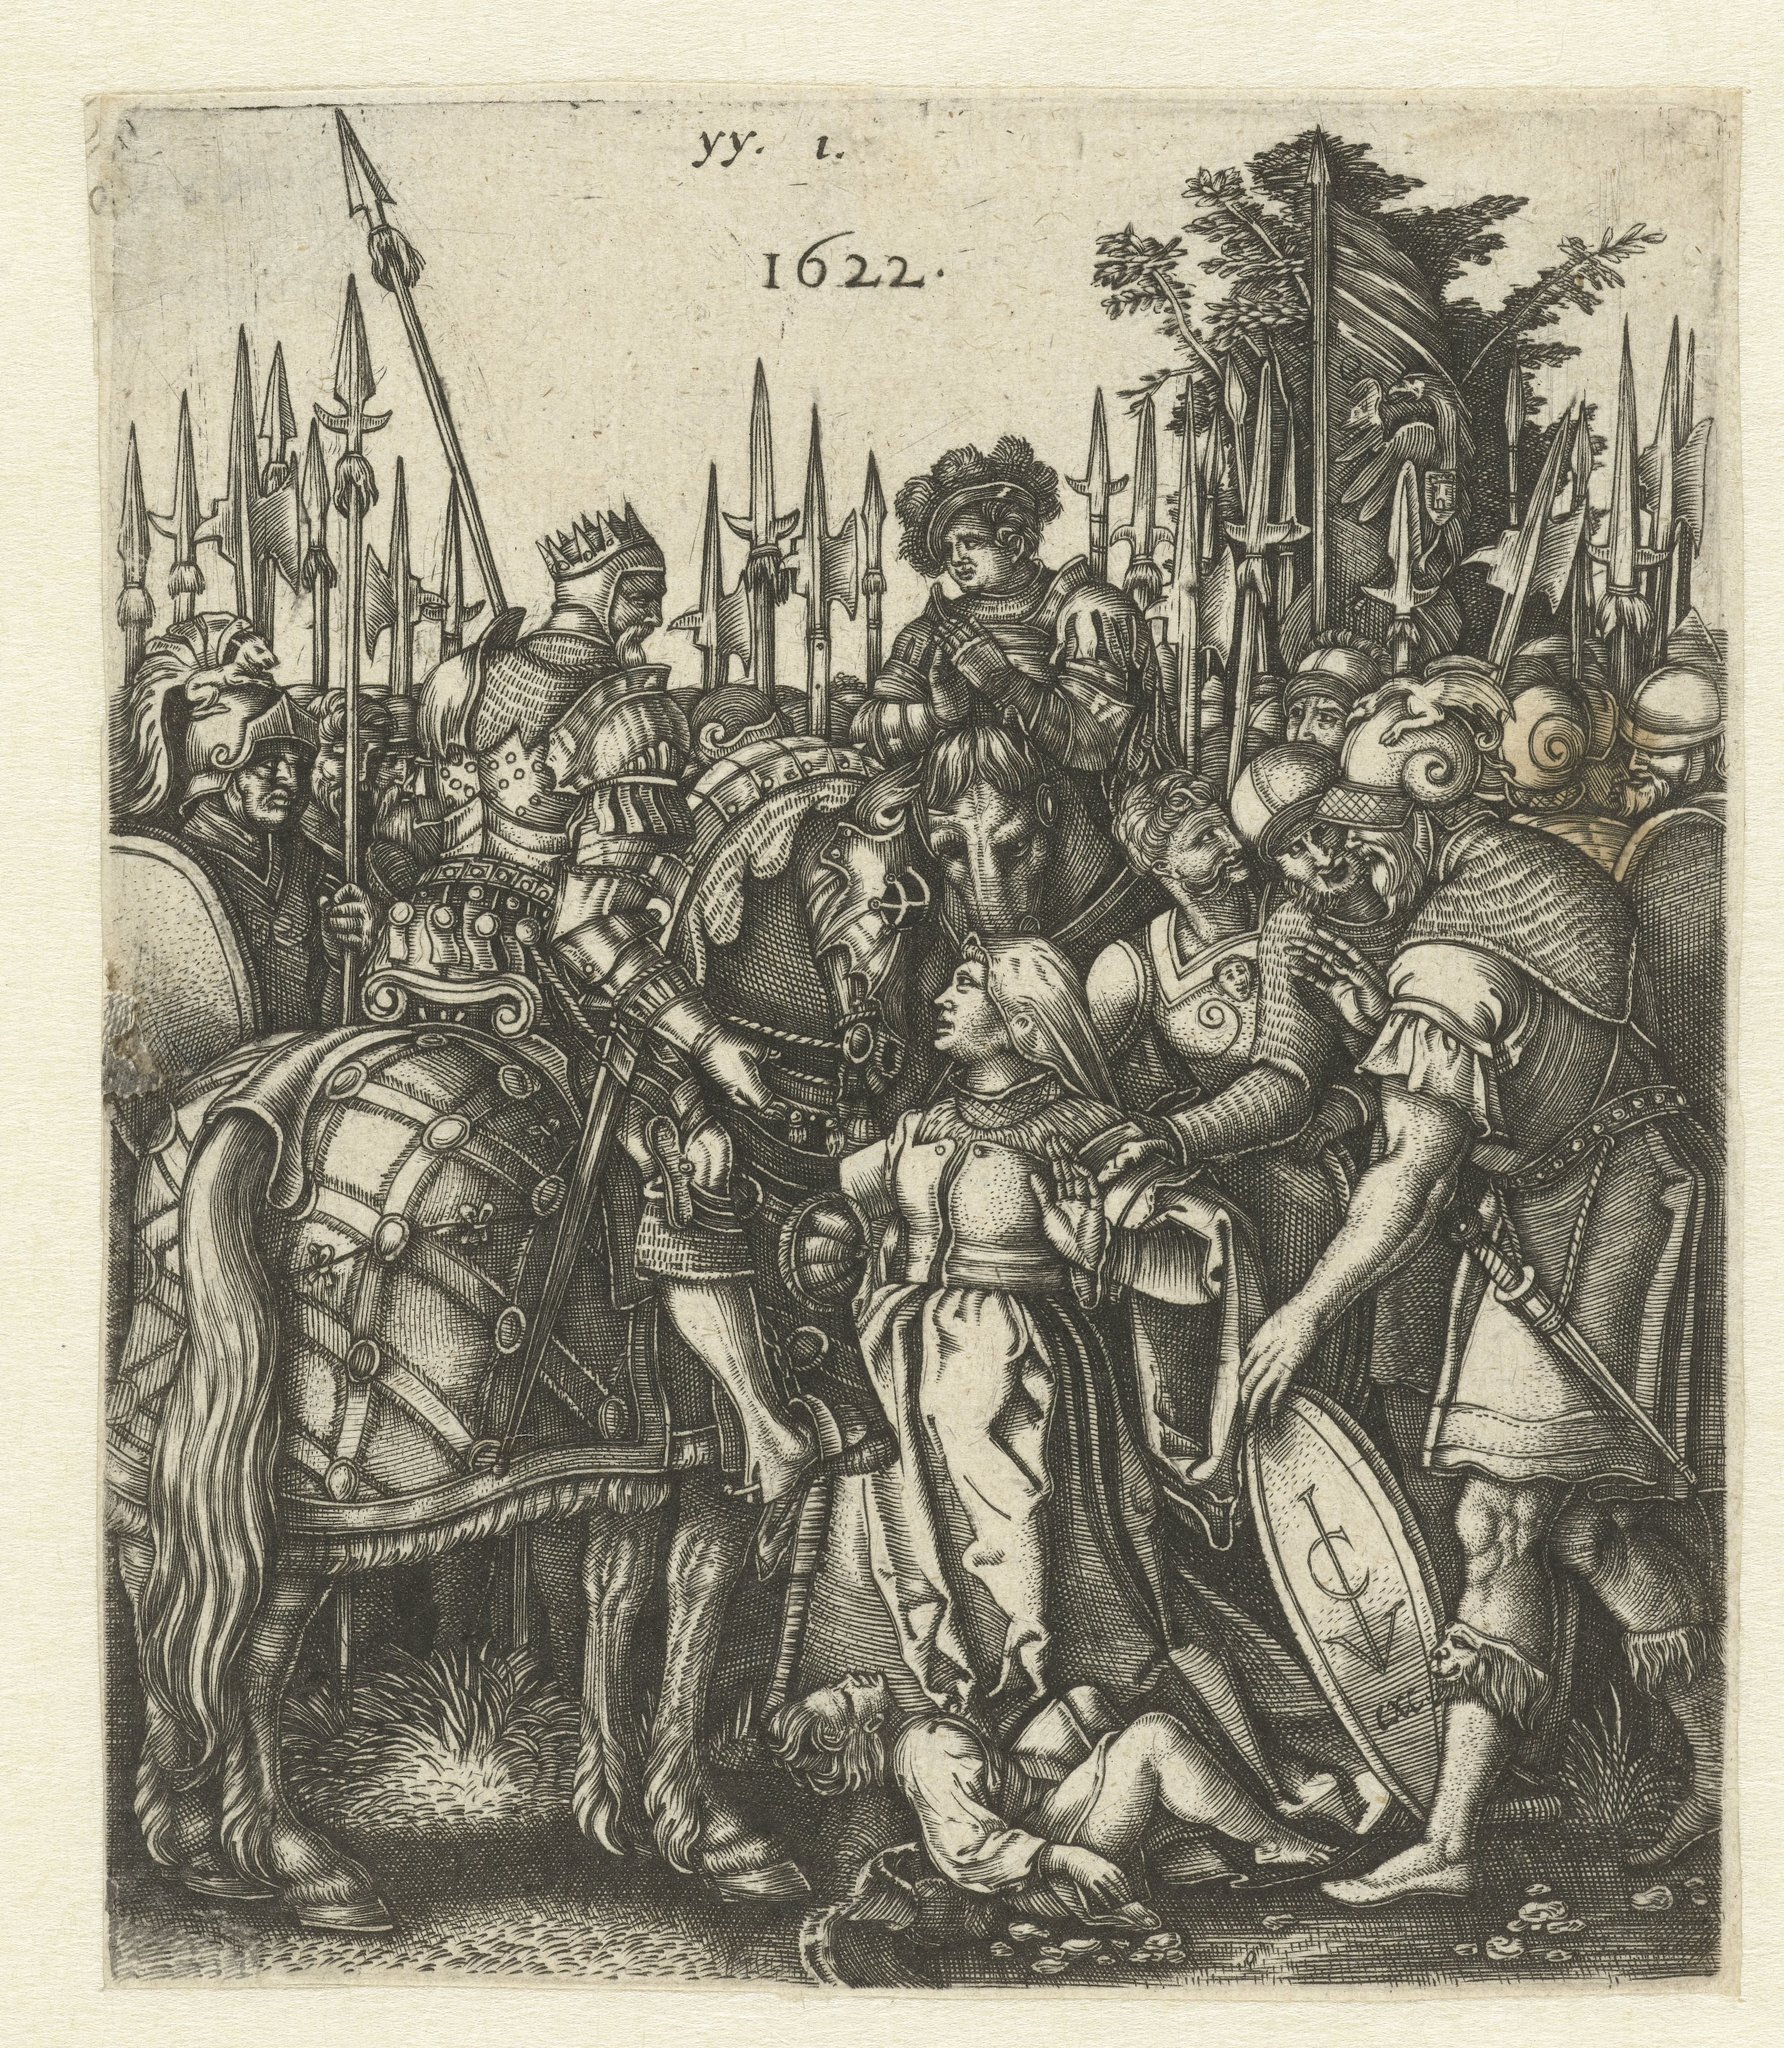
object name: print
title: Gerechtigheid van Trajanus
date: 1622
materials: paper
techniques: engraving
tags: the emperor riding out is stopped by the mother of the dead baby ~ justice of trajan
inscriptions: collector's mark: Lugt 240, number: ‘yy. 1.’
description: Kopie in spiegelbeeld naar een prent van Hans Sebald Beham op een groter formaat. De zoon van een weduwe is gedood door een soldaat van keizer Trajanus. Knielend bij het dode lichaam van haar zoon wijst ze de keizer op dit onrecht.